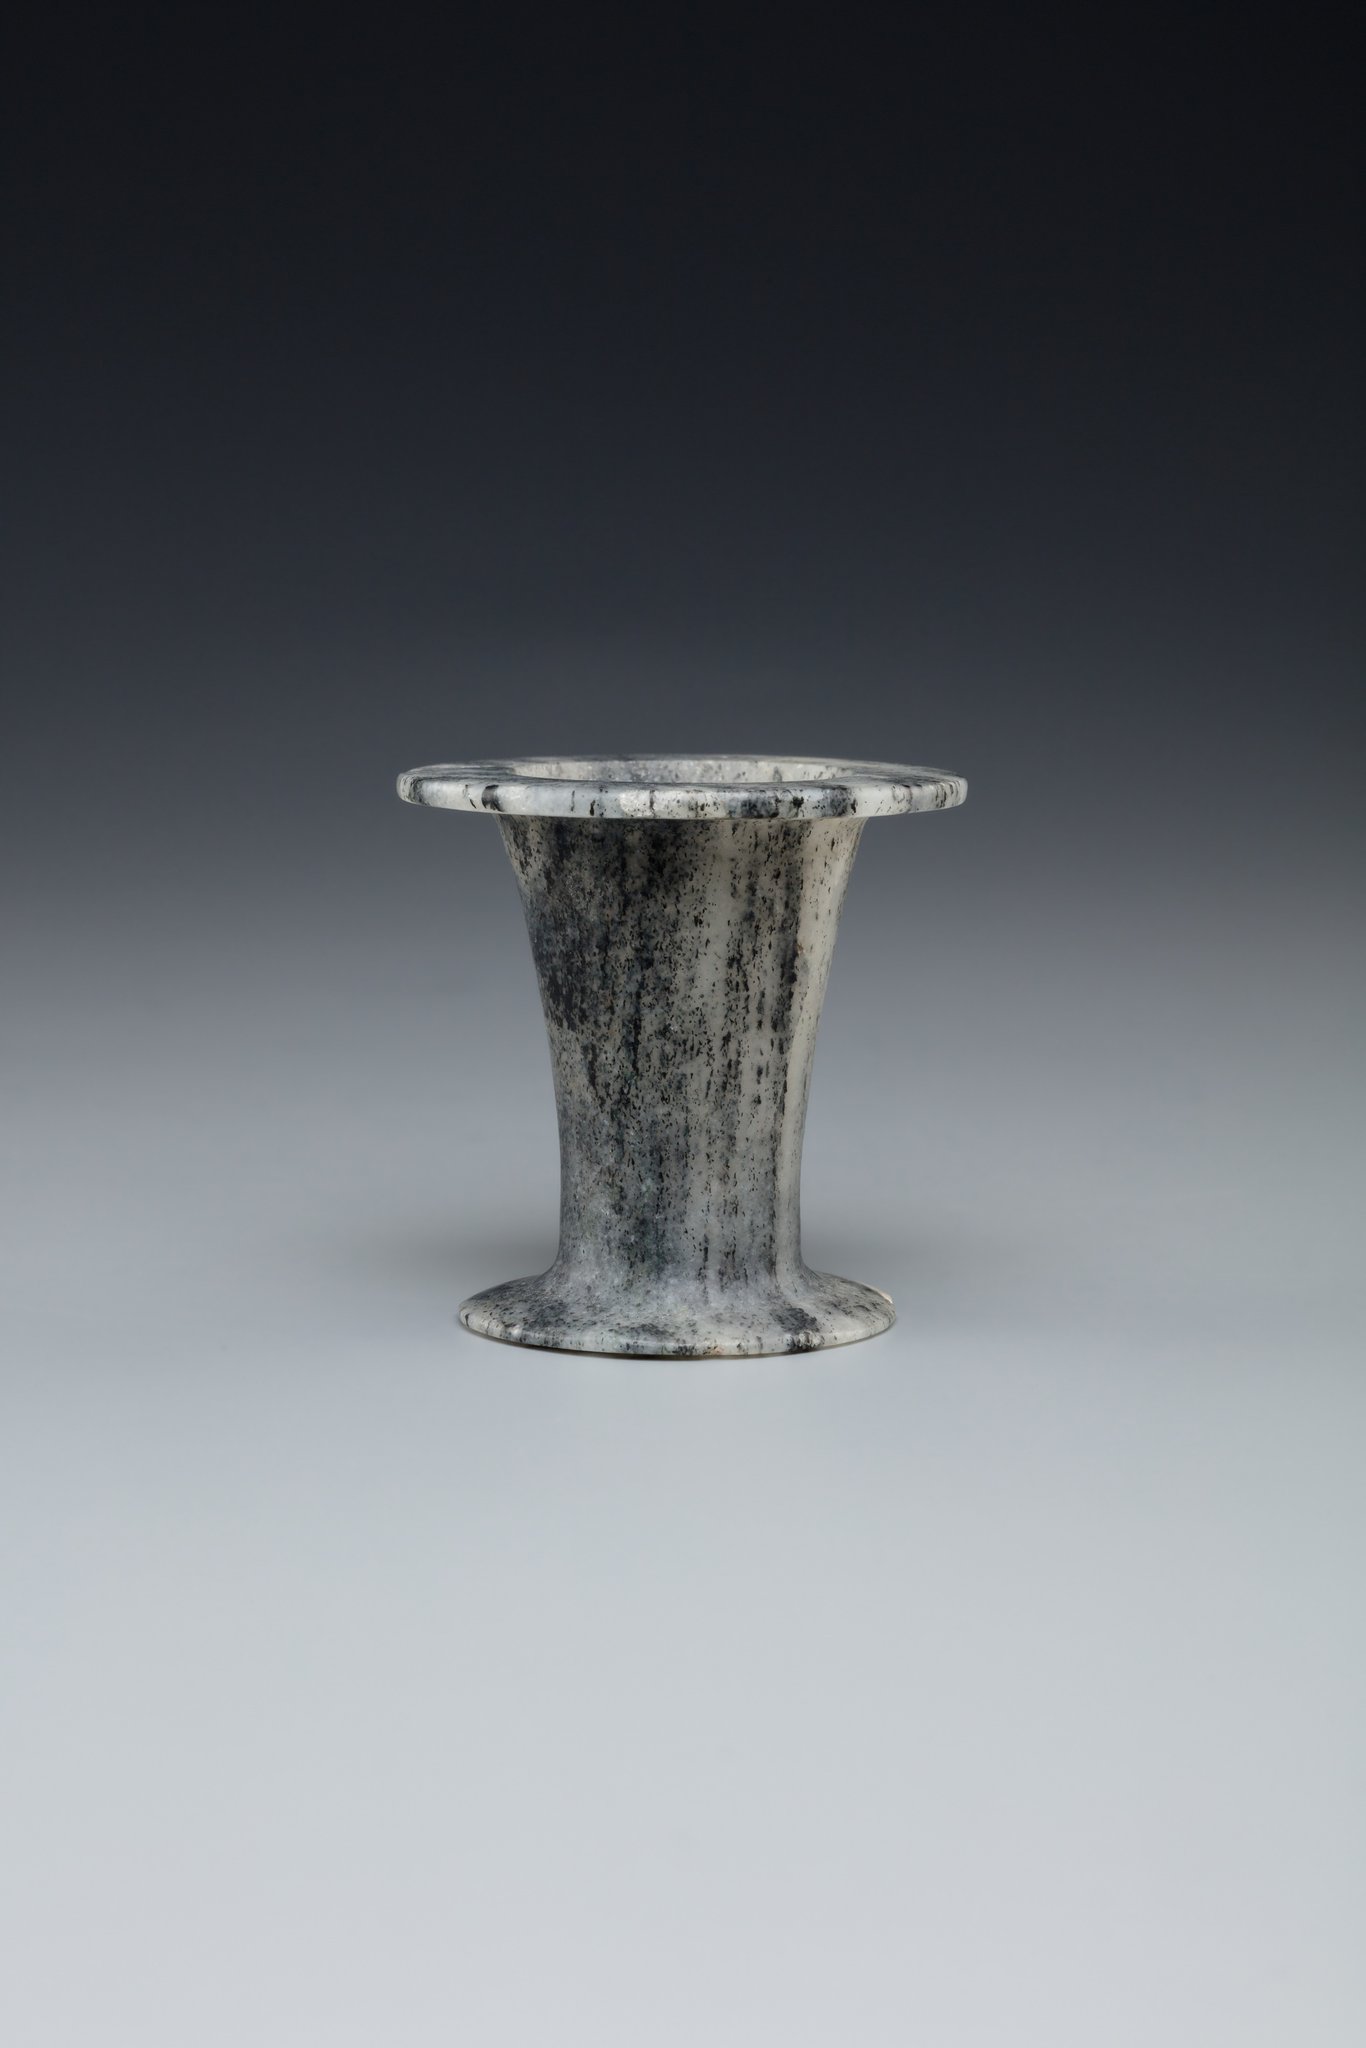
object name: miniature ointment jar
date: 2465-2150 BCE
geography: egypt